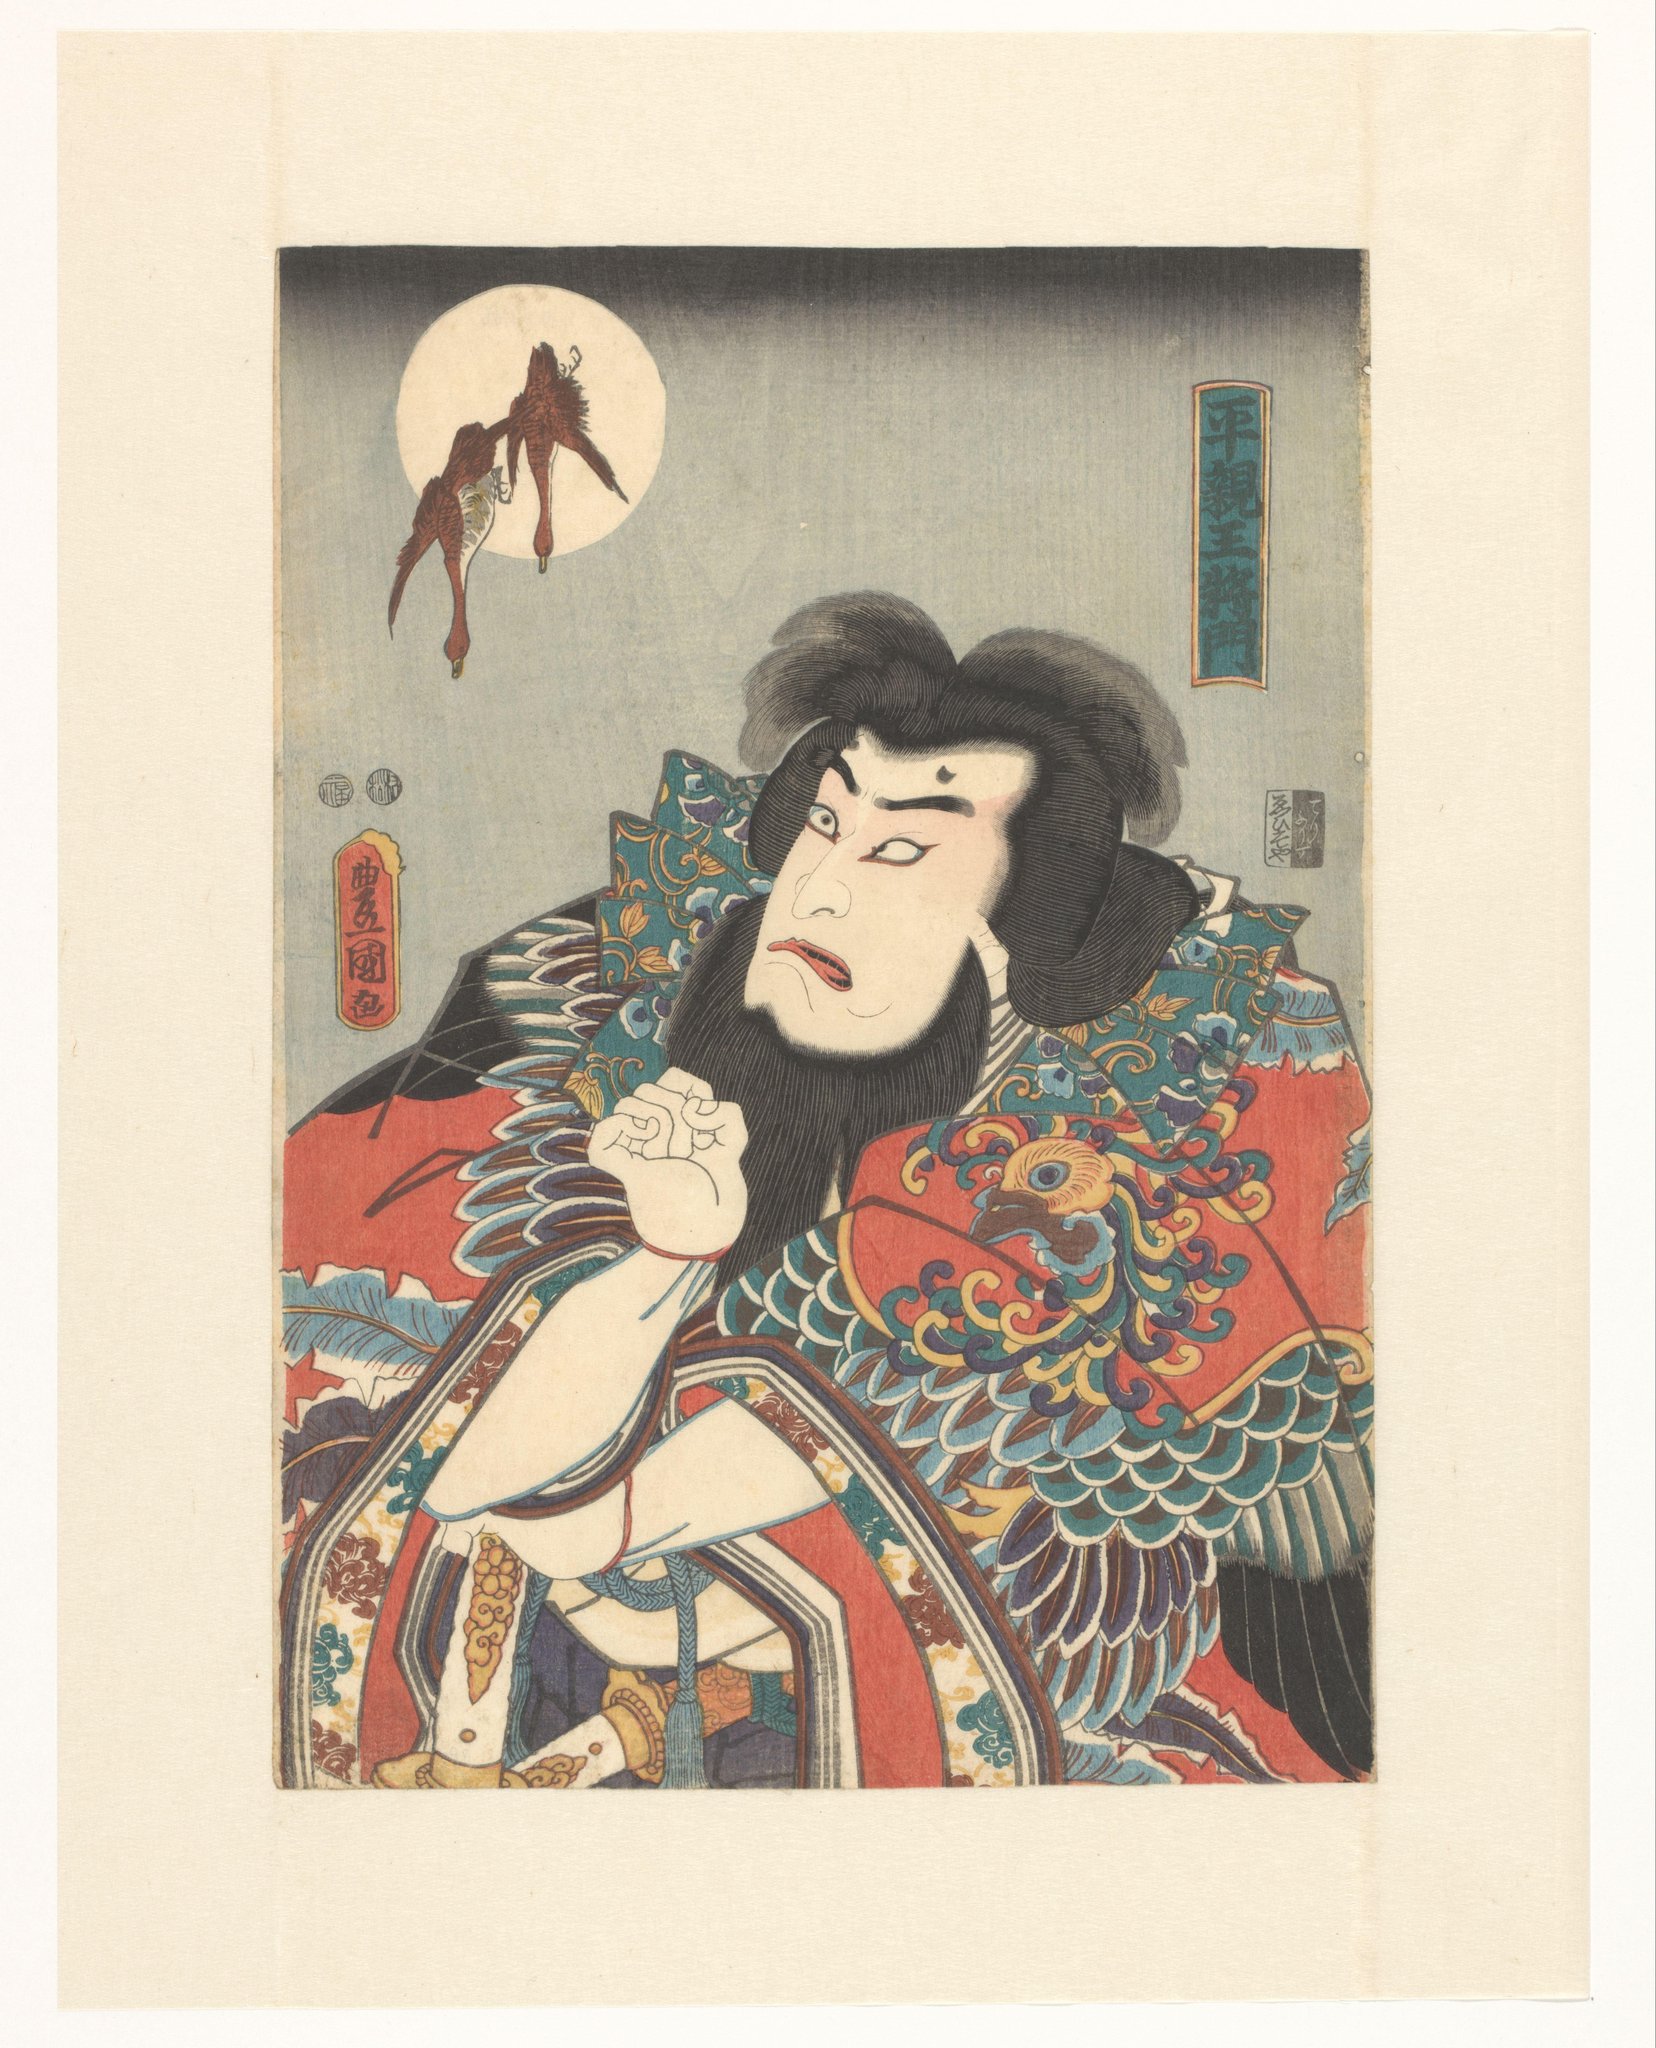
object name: print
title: The new Taira emperor Masakado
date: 1849-1852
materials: paper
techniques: woodcut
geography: japan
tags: water-birds: goose, emperor, actor (on the stage)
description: Kabuki acteur Nakamura Utaemon IV in de rol van de zelf uitgeroepen nieuwe keizer Masakado, met baard, kijkt omhoog naar twee ganzen die naar beneden lijken te vallen. Bij volle maan. De zwarte tanden en de vorm van de opgeschilderde wenkbrauwen zijn kenmerkend voor hooggeplaatste hovelingen. Het verenpatroon op zijn kleding verwijst naar keizerlijke macht. Wilde ganzen die hun koers wijzigen verwijzen naar de aanwezigheid van een vijand.